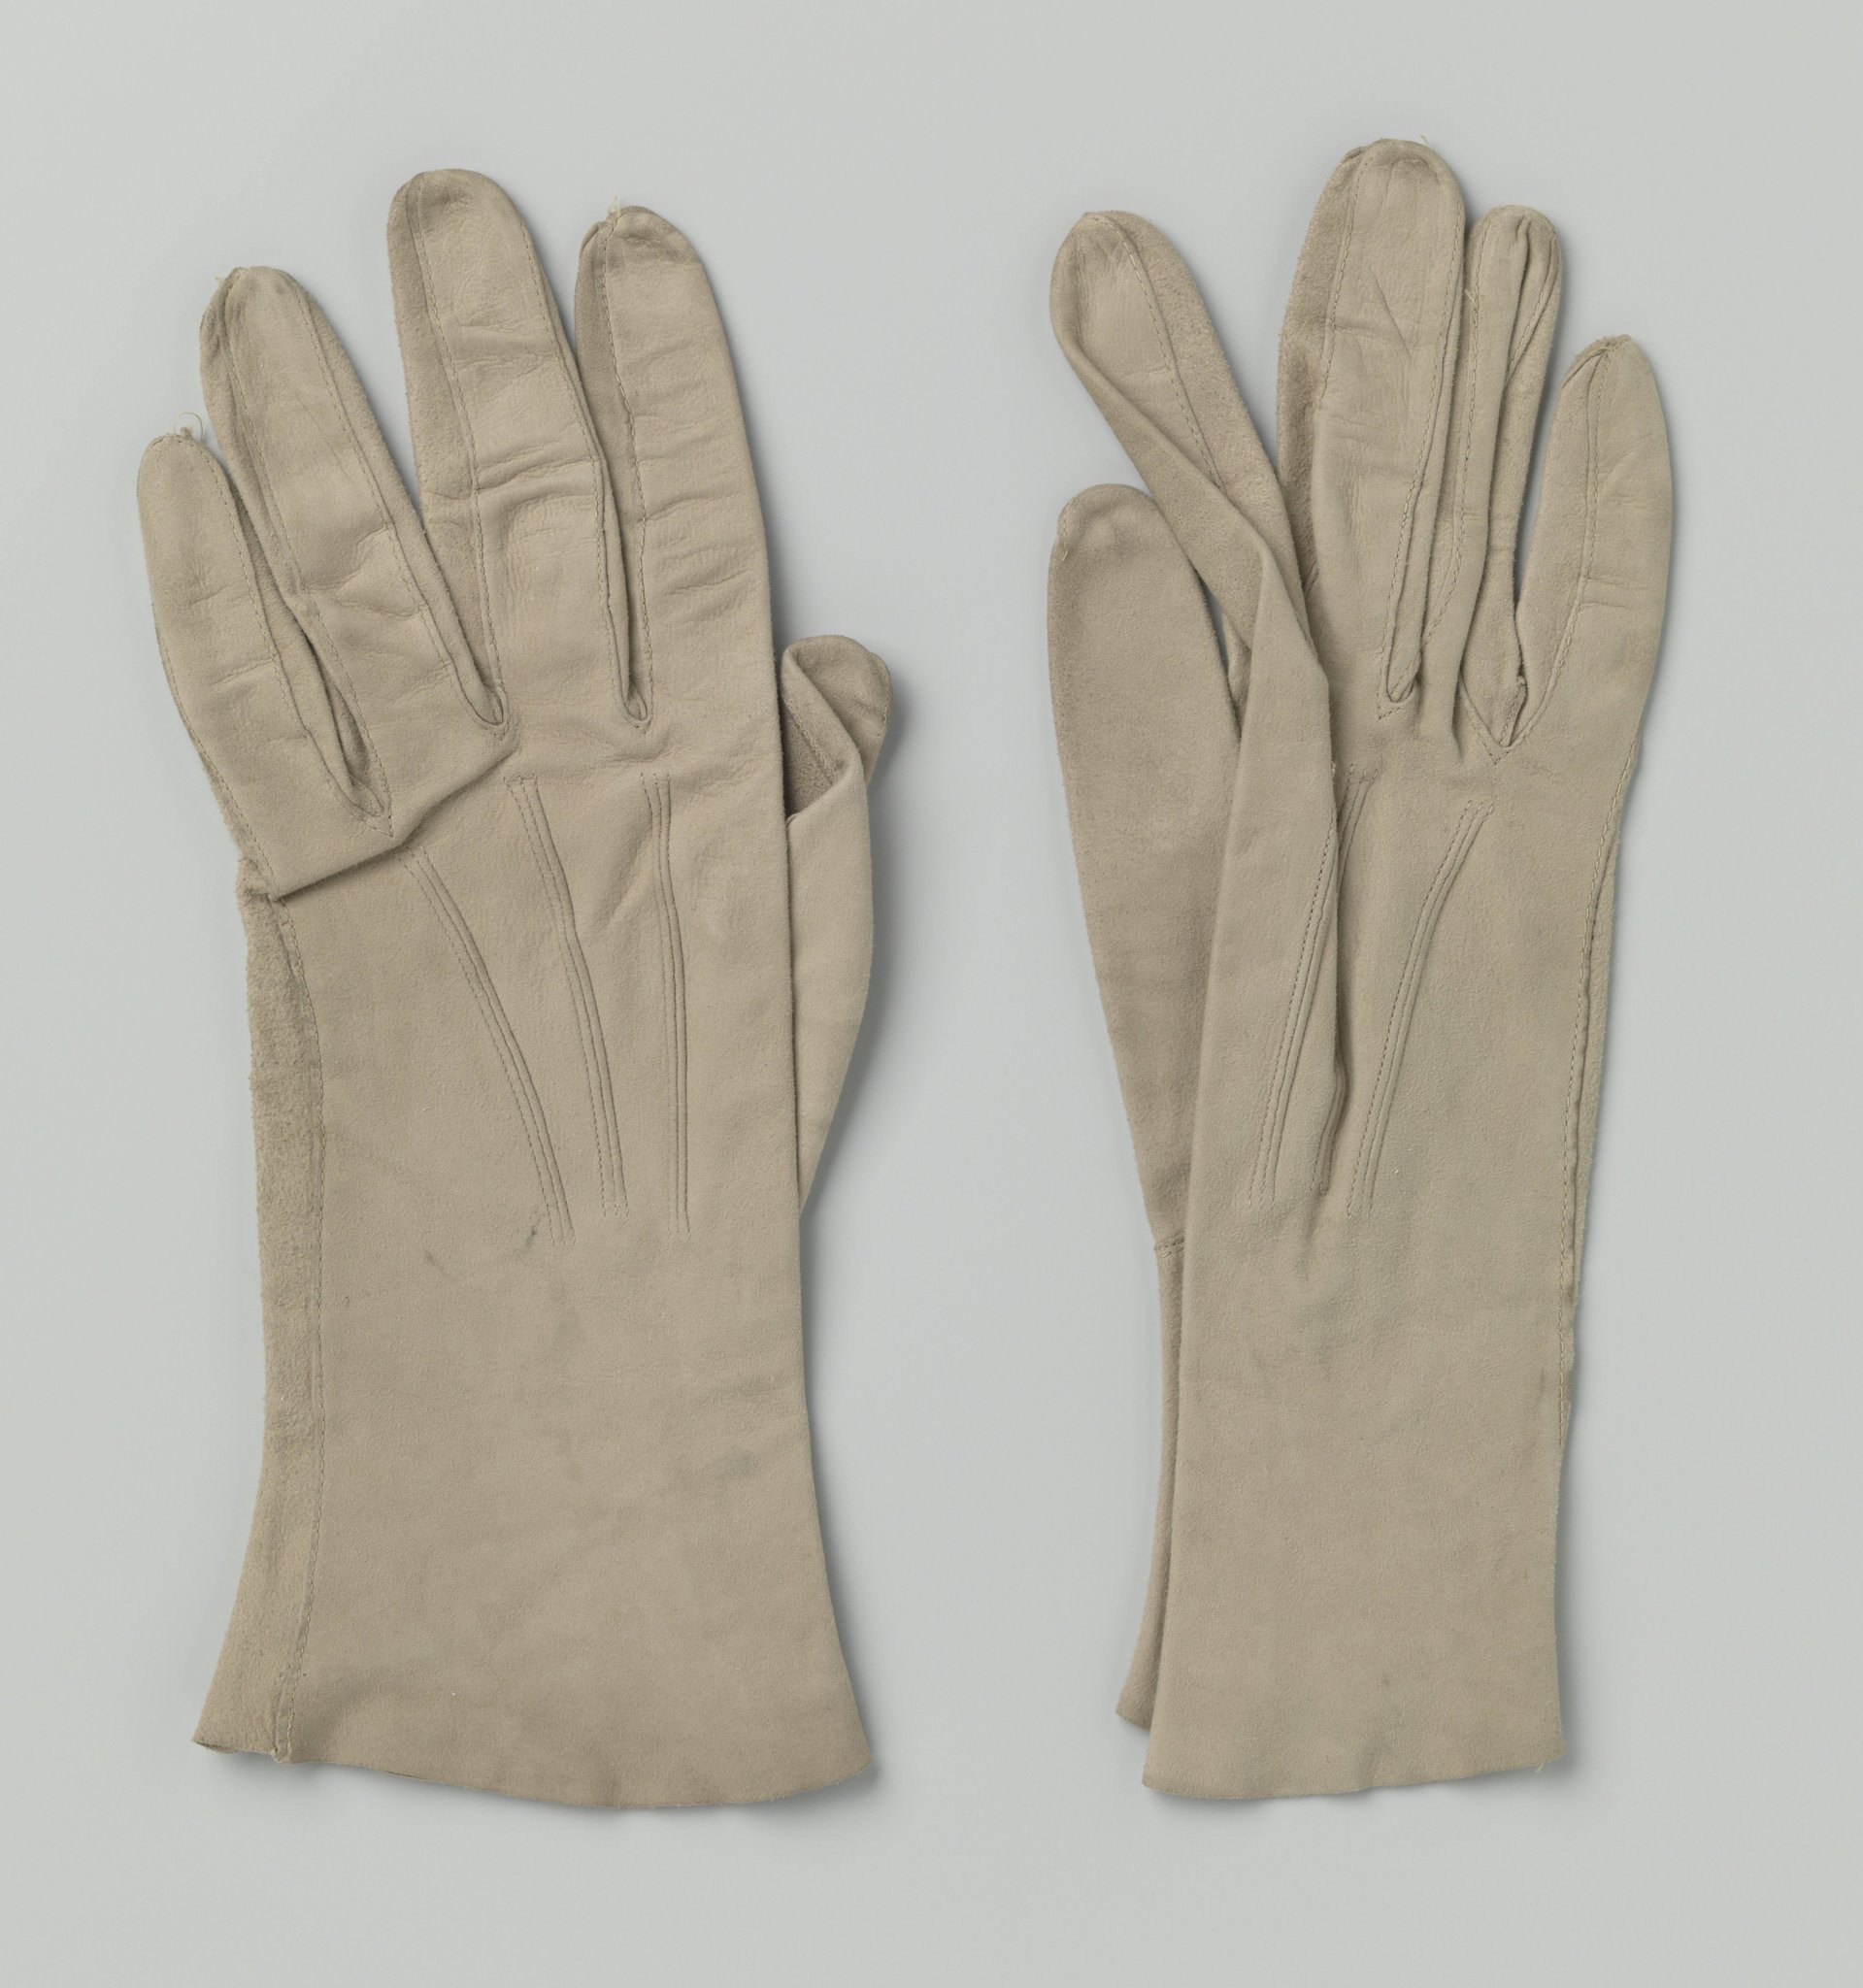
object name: glove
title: Handschoen in leverkleurig zeemleer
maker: Anonymous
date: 1926-1950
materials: leather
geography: western europe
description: Linker handschoen in leverkleurig zeemleer. Op de rug drie uitstralende koorden.